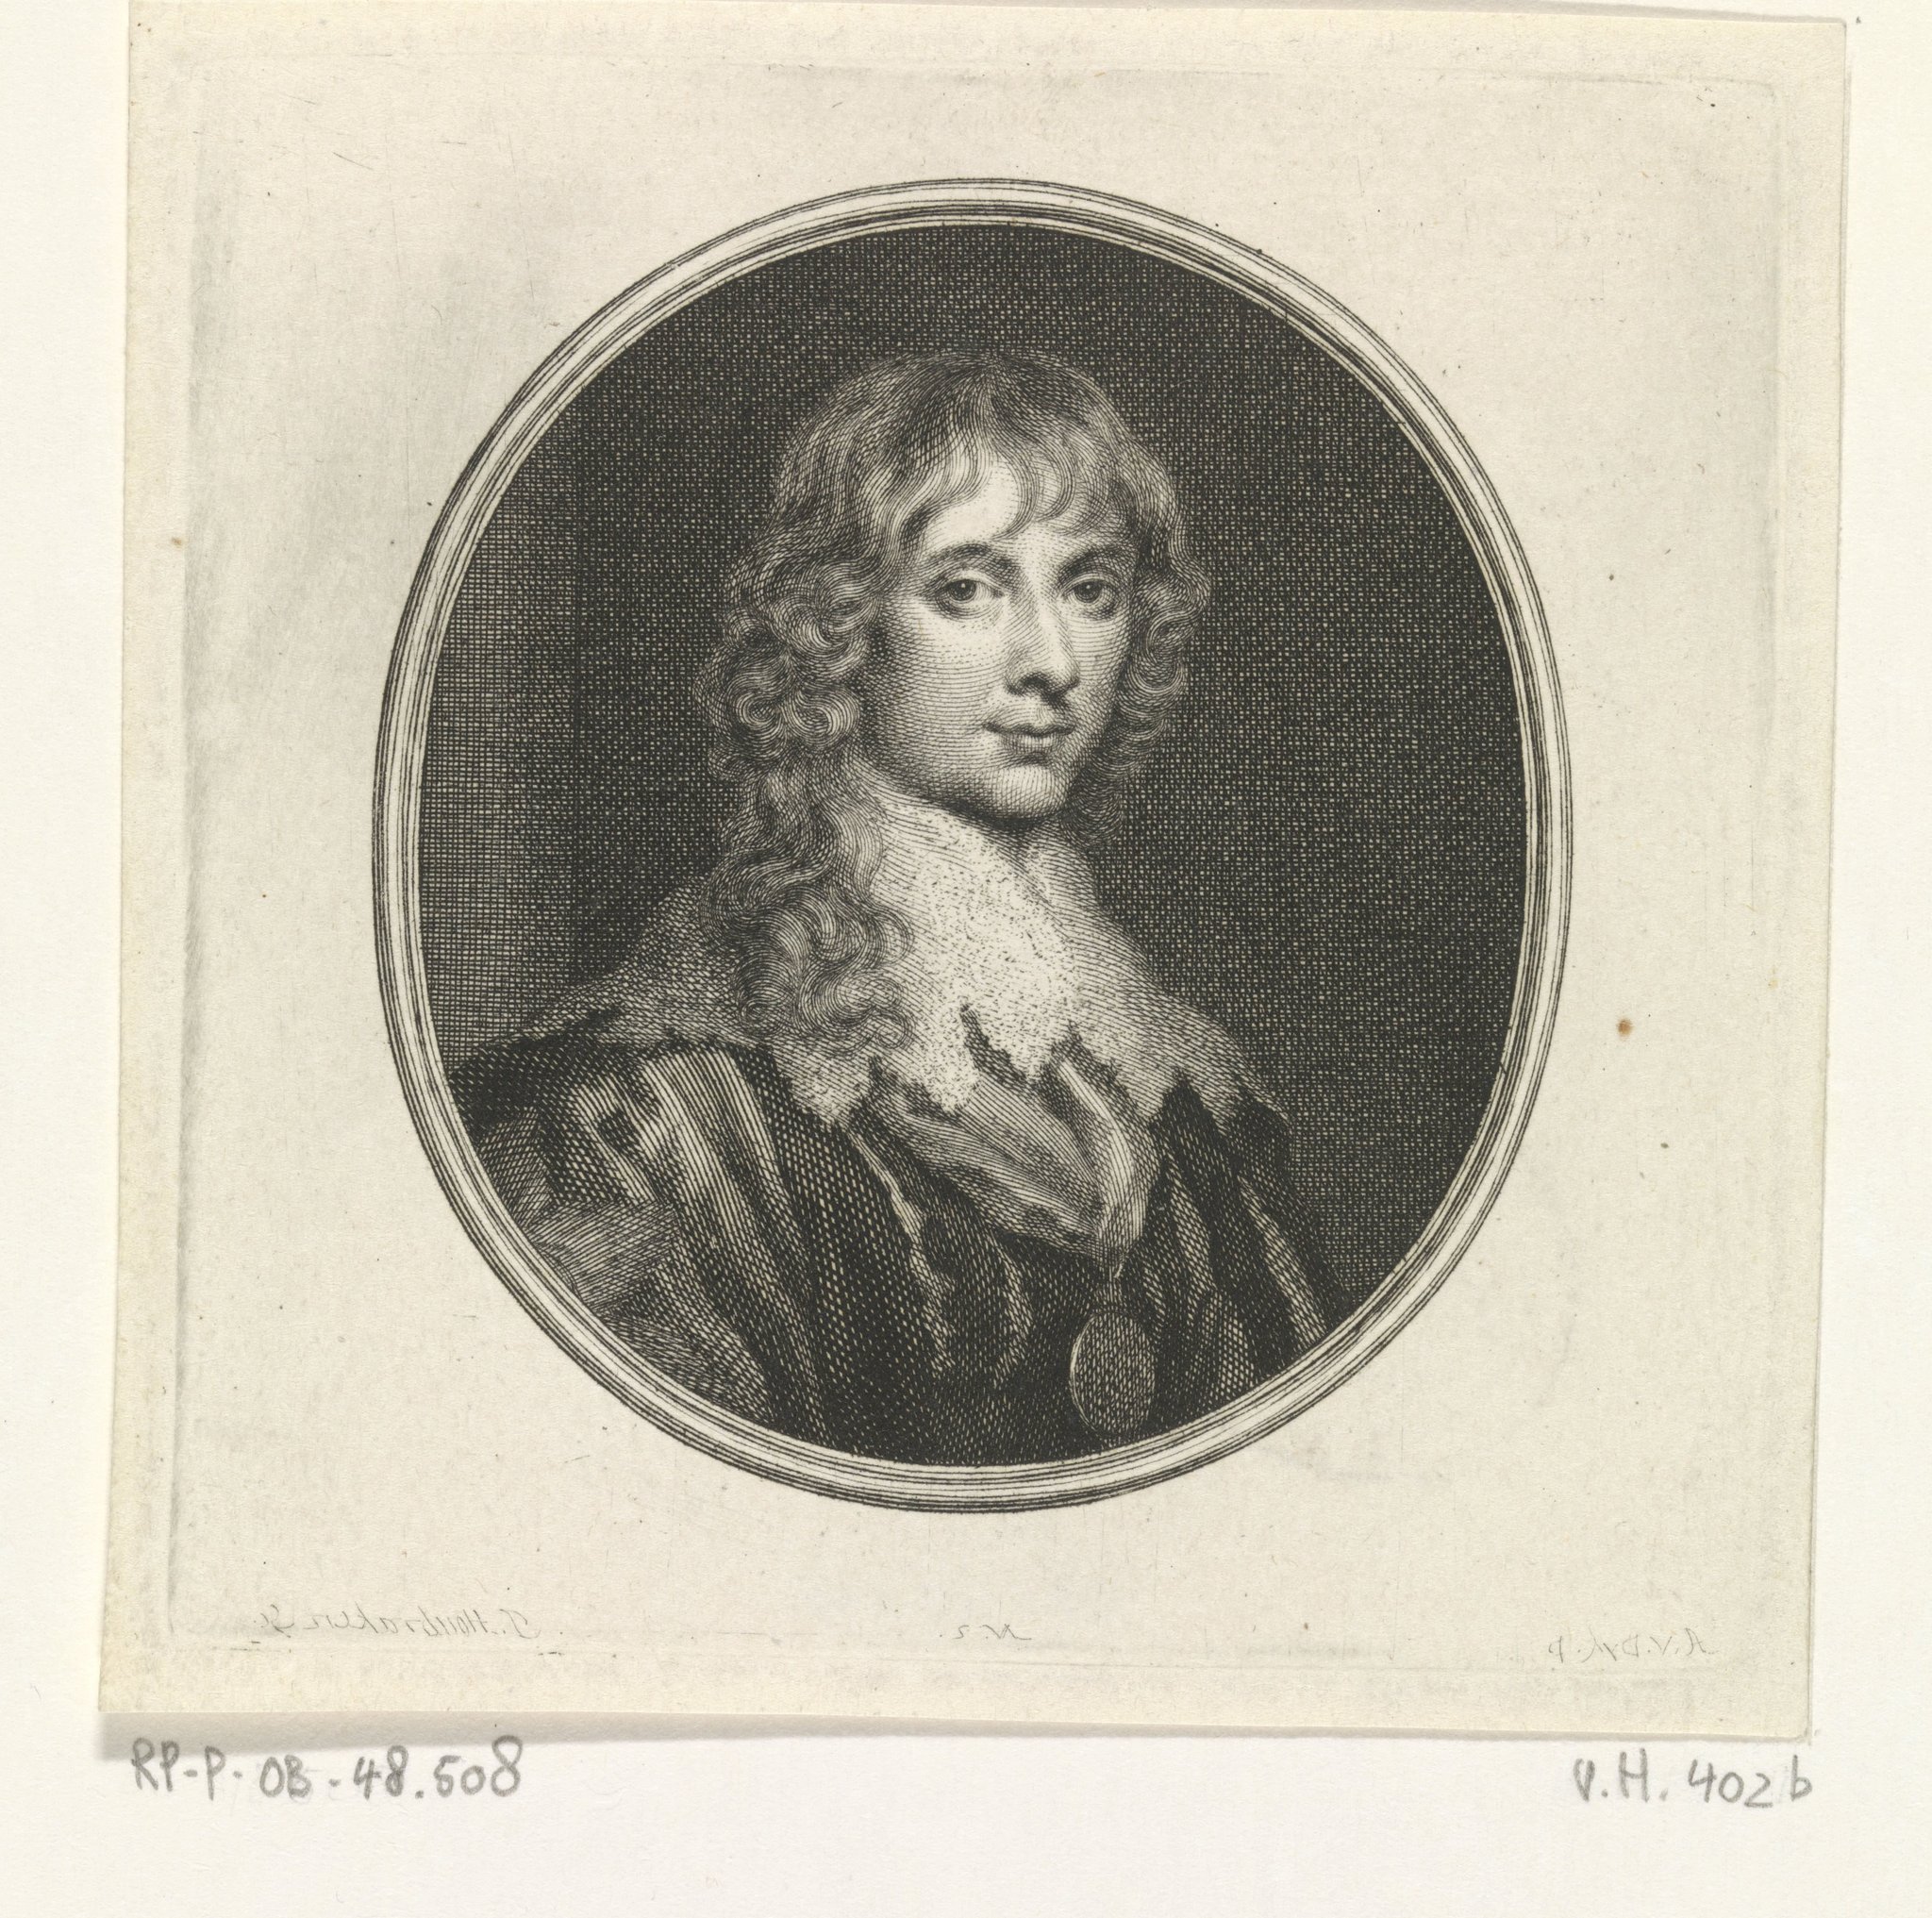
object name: print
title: Portret van James Stuart, hertog van Richmond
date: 1708-1780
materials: paper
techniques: engraving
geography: amsterdam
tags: prins, james stuart (1e hertog van richmond en 4e hertog van lennox)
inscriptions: collector's mark: Lugt 240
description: Buste naar rechts van James Stuart, hertog van Richmond, in een ovaal medaillon.